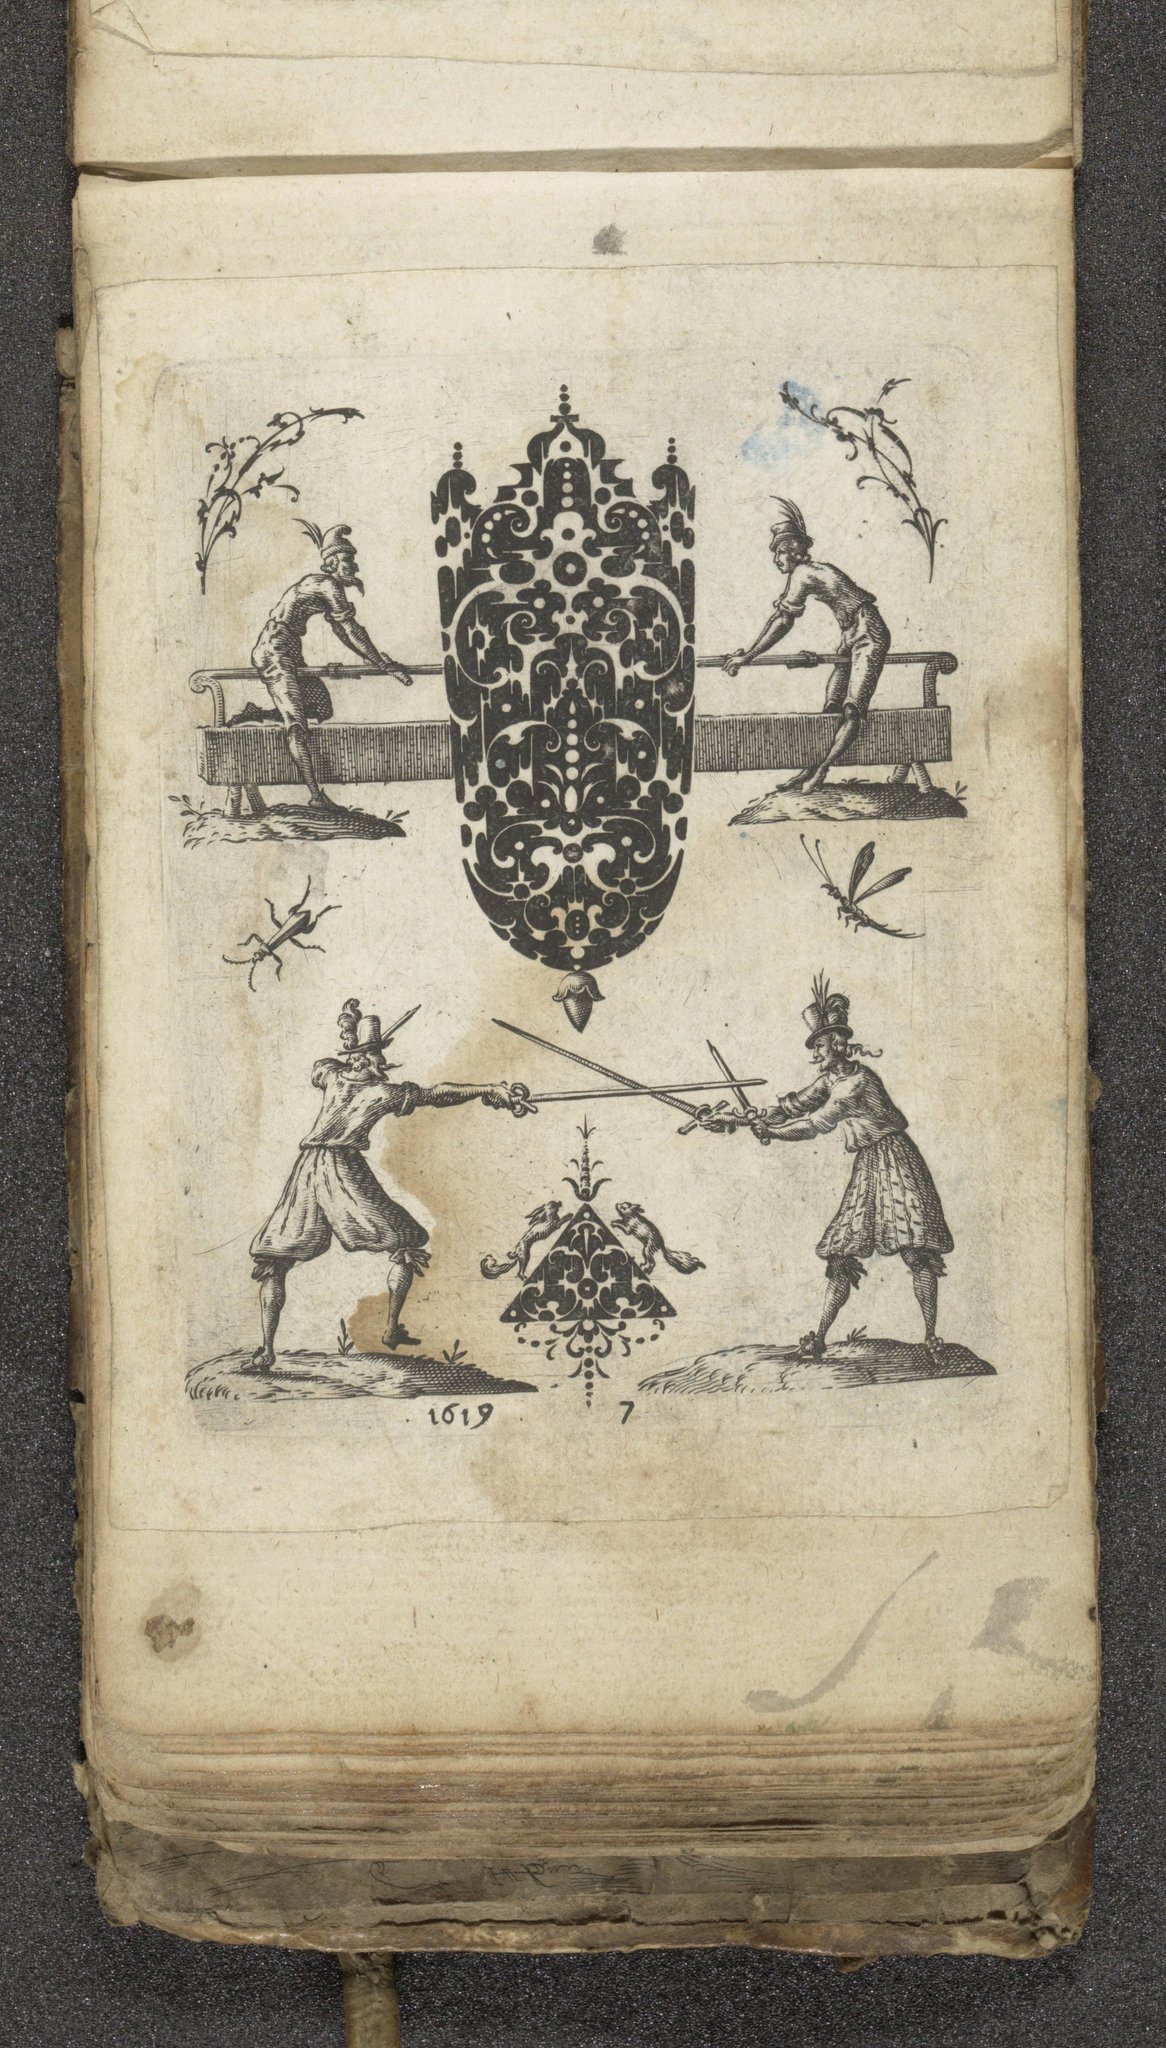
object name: ornament print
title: Zwartornamenten in de vorm van een hanger en een driehoek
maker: jean toutin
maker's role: print maker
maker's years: 1578-1644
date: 1619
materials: paper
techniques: engraving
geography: châteaudun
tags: ornaments ~ art, fighting contest (sport), rodents: squirrel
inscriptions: inscription: ‘66’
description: Twee zwartornamenten in de vorm van een hanger en een driehoek. Daarbij twee mannen bij een schaafbank (?), twee zwaardvechters, twee insecten en twee eekhoorns. Midden onder genummerd 7. De prent maakt deel uit van een album.